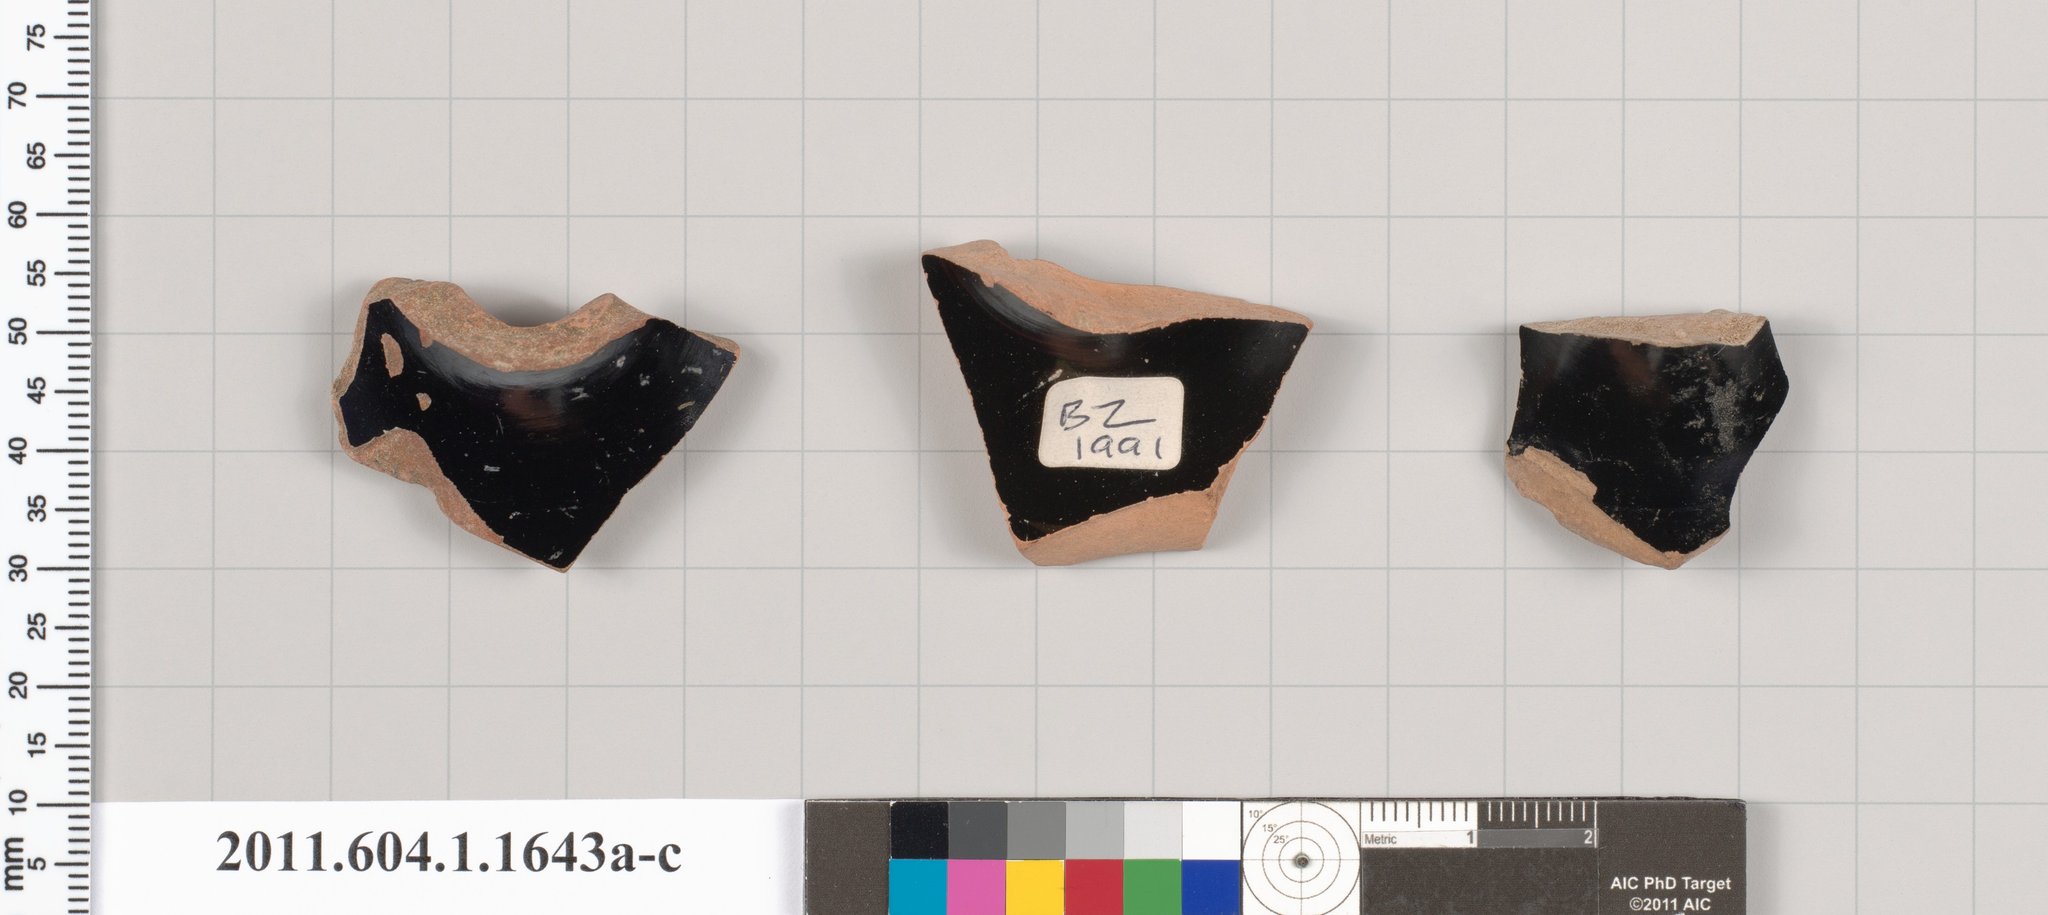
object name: kylix fragment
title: Terracotta fragments of kylikes (drinking cups)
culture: greek, attic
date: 500-401 BCE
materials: terracotta